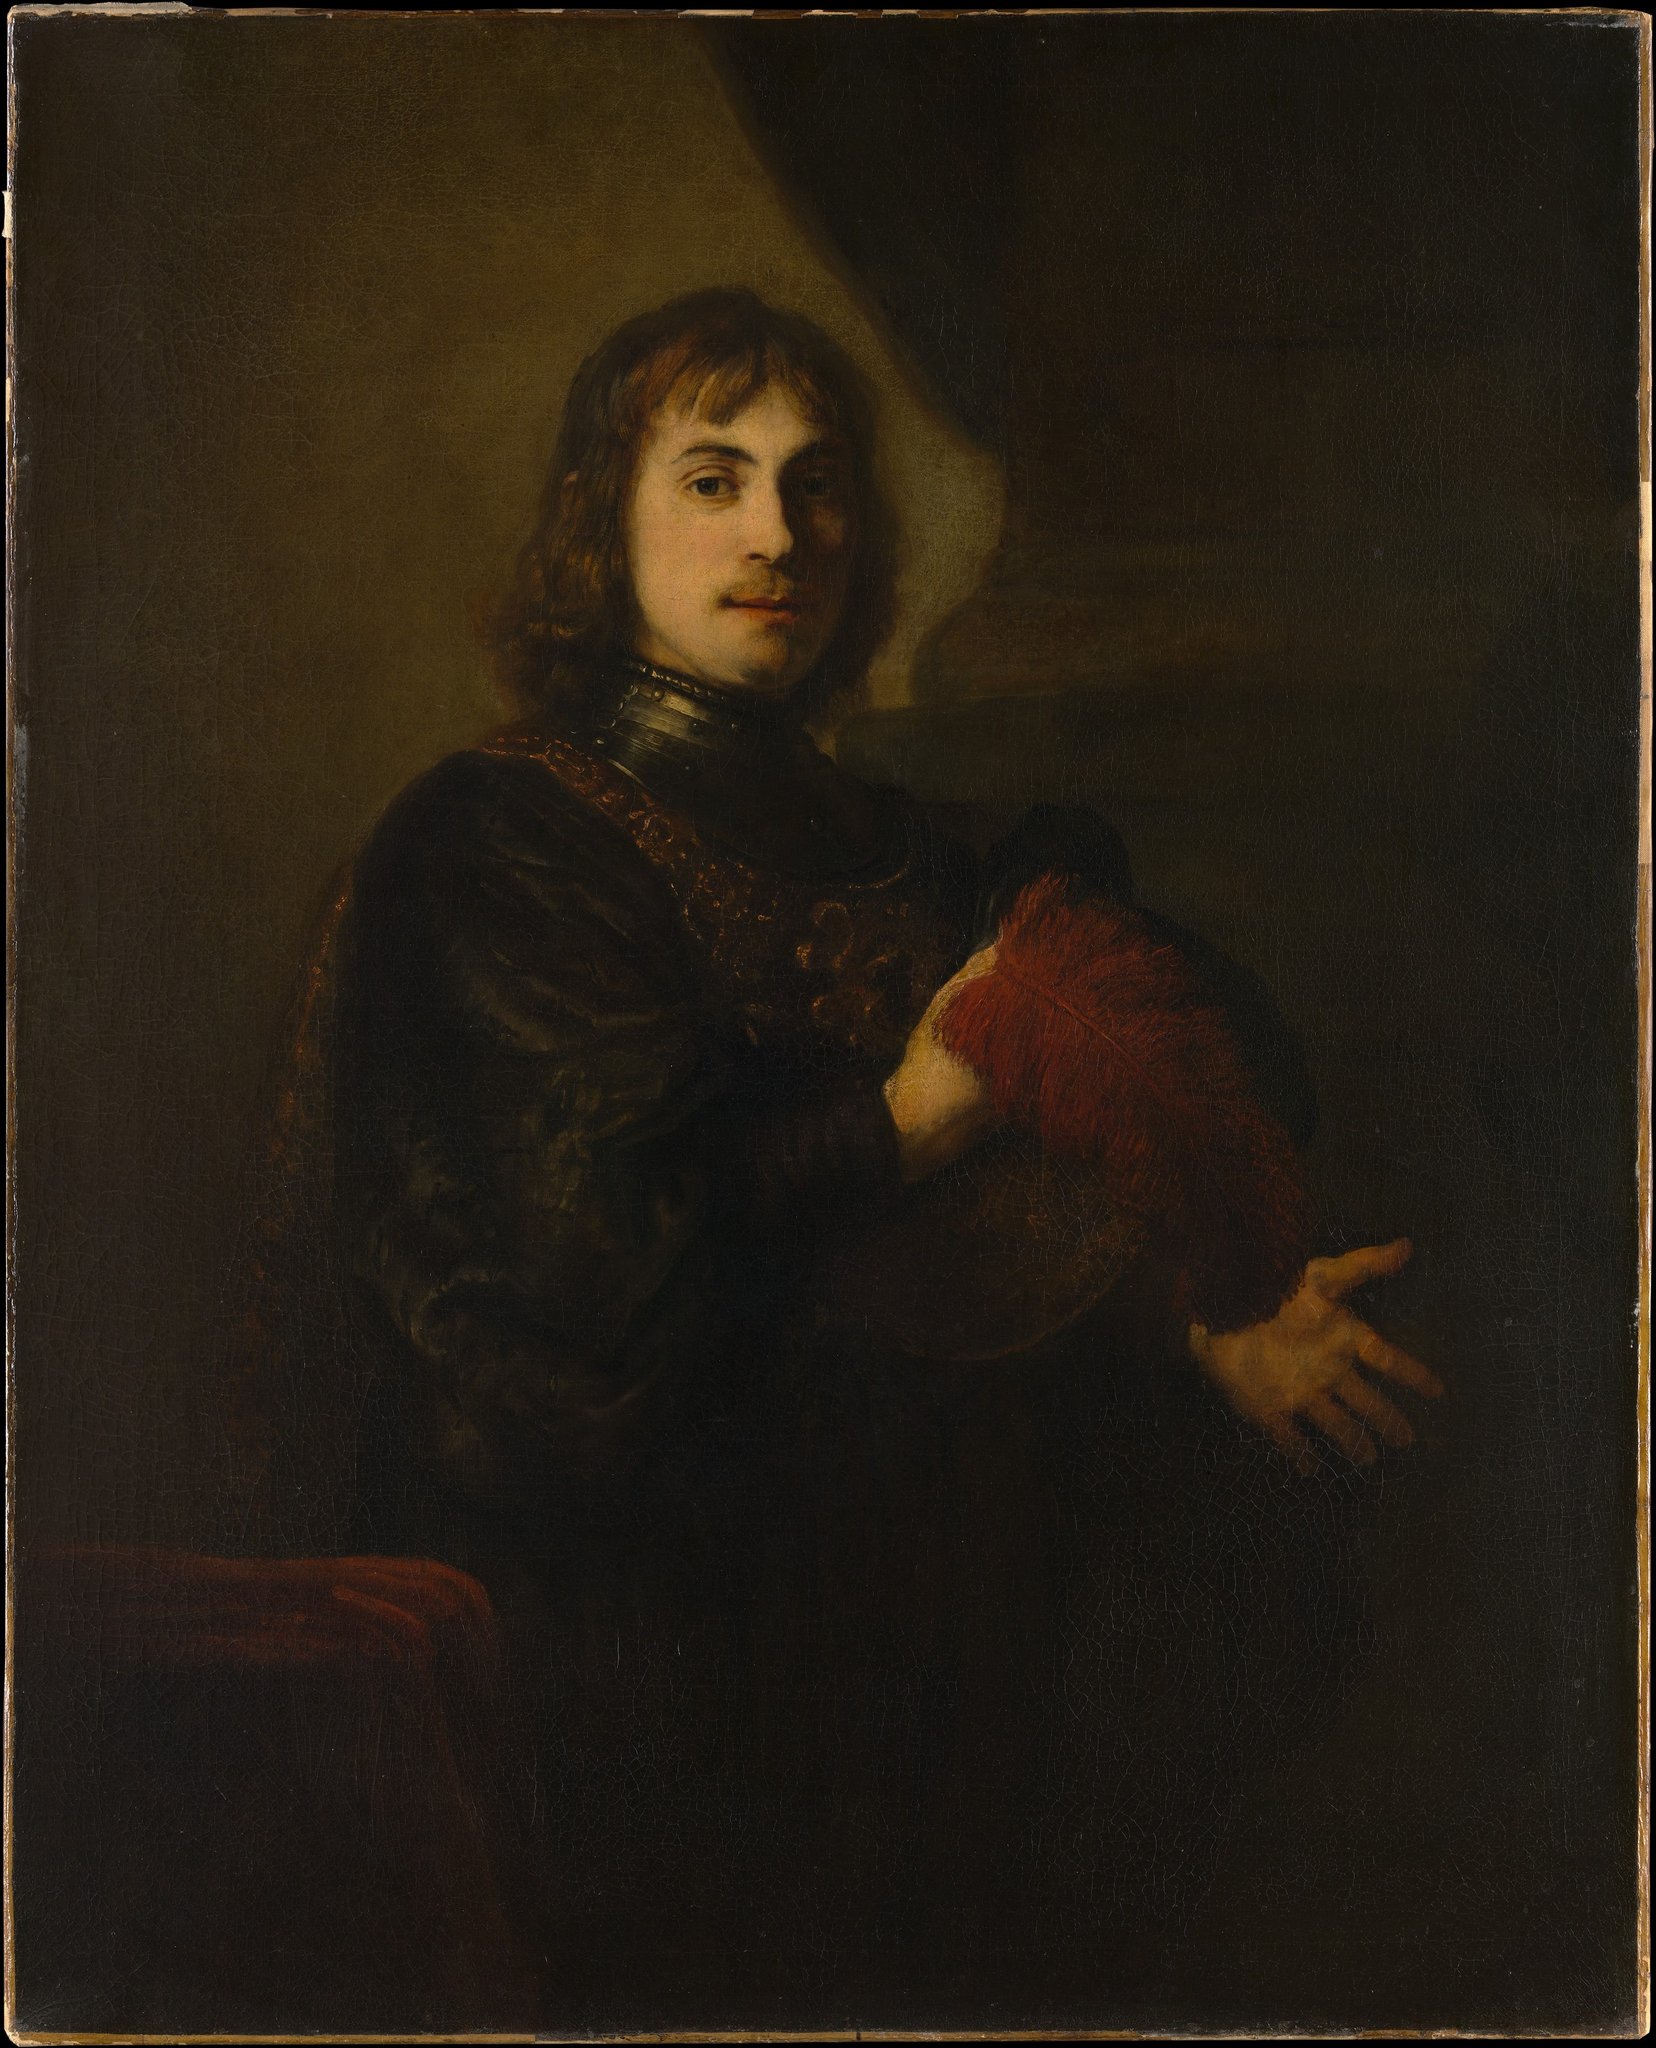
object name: painting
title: Portrait of a Man with a Breastplate and Plumed Hat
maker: rembrandt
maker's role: artist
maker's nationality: dutch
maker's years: 1606-1669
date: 1625-1674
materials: canvas, oil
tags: men,portraits